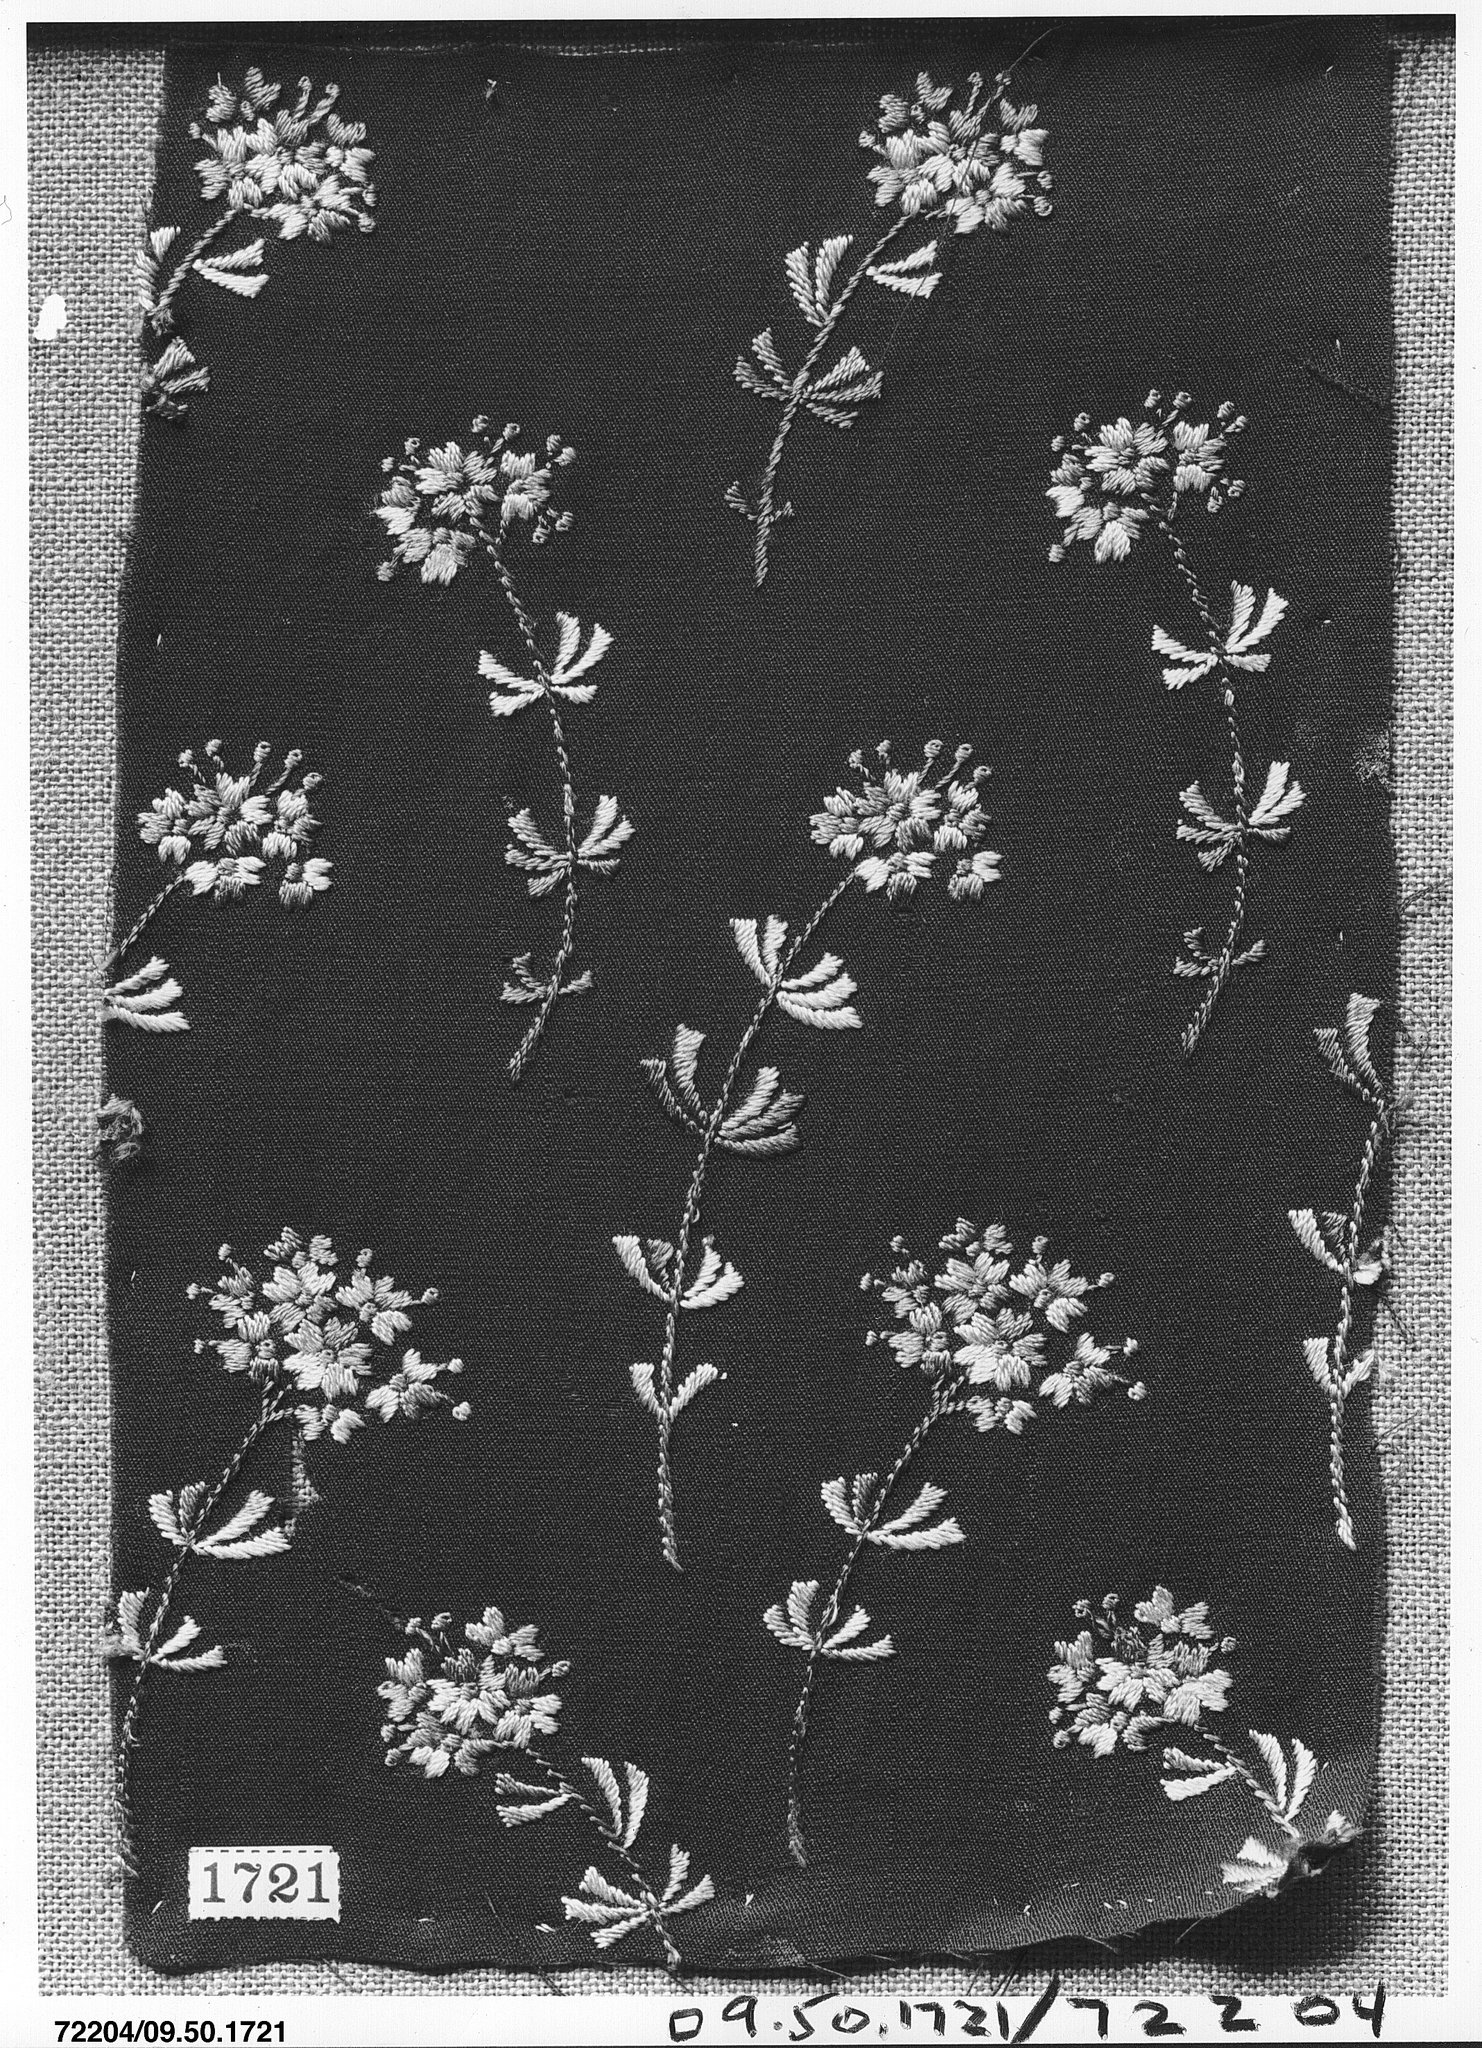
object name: fragment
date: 1801-1900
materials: wool